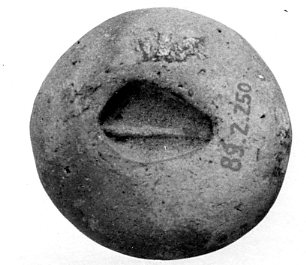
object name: mold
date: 1550-1295 BCE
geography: egypt